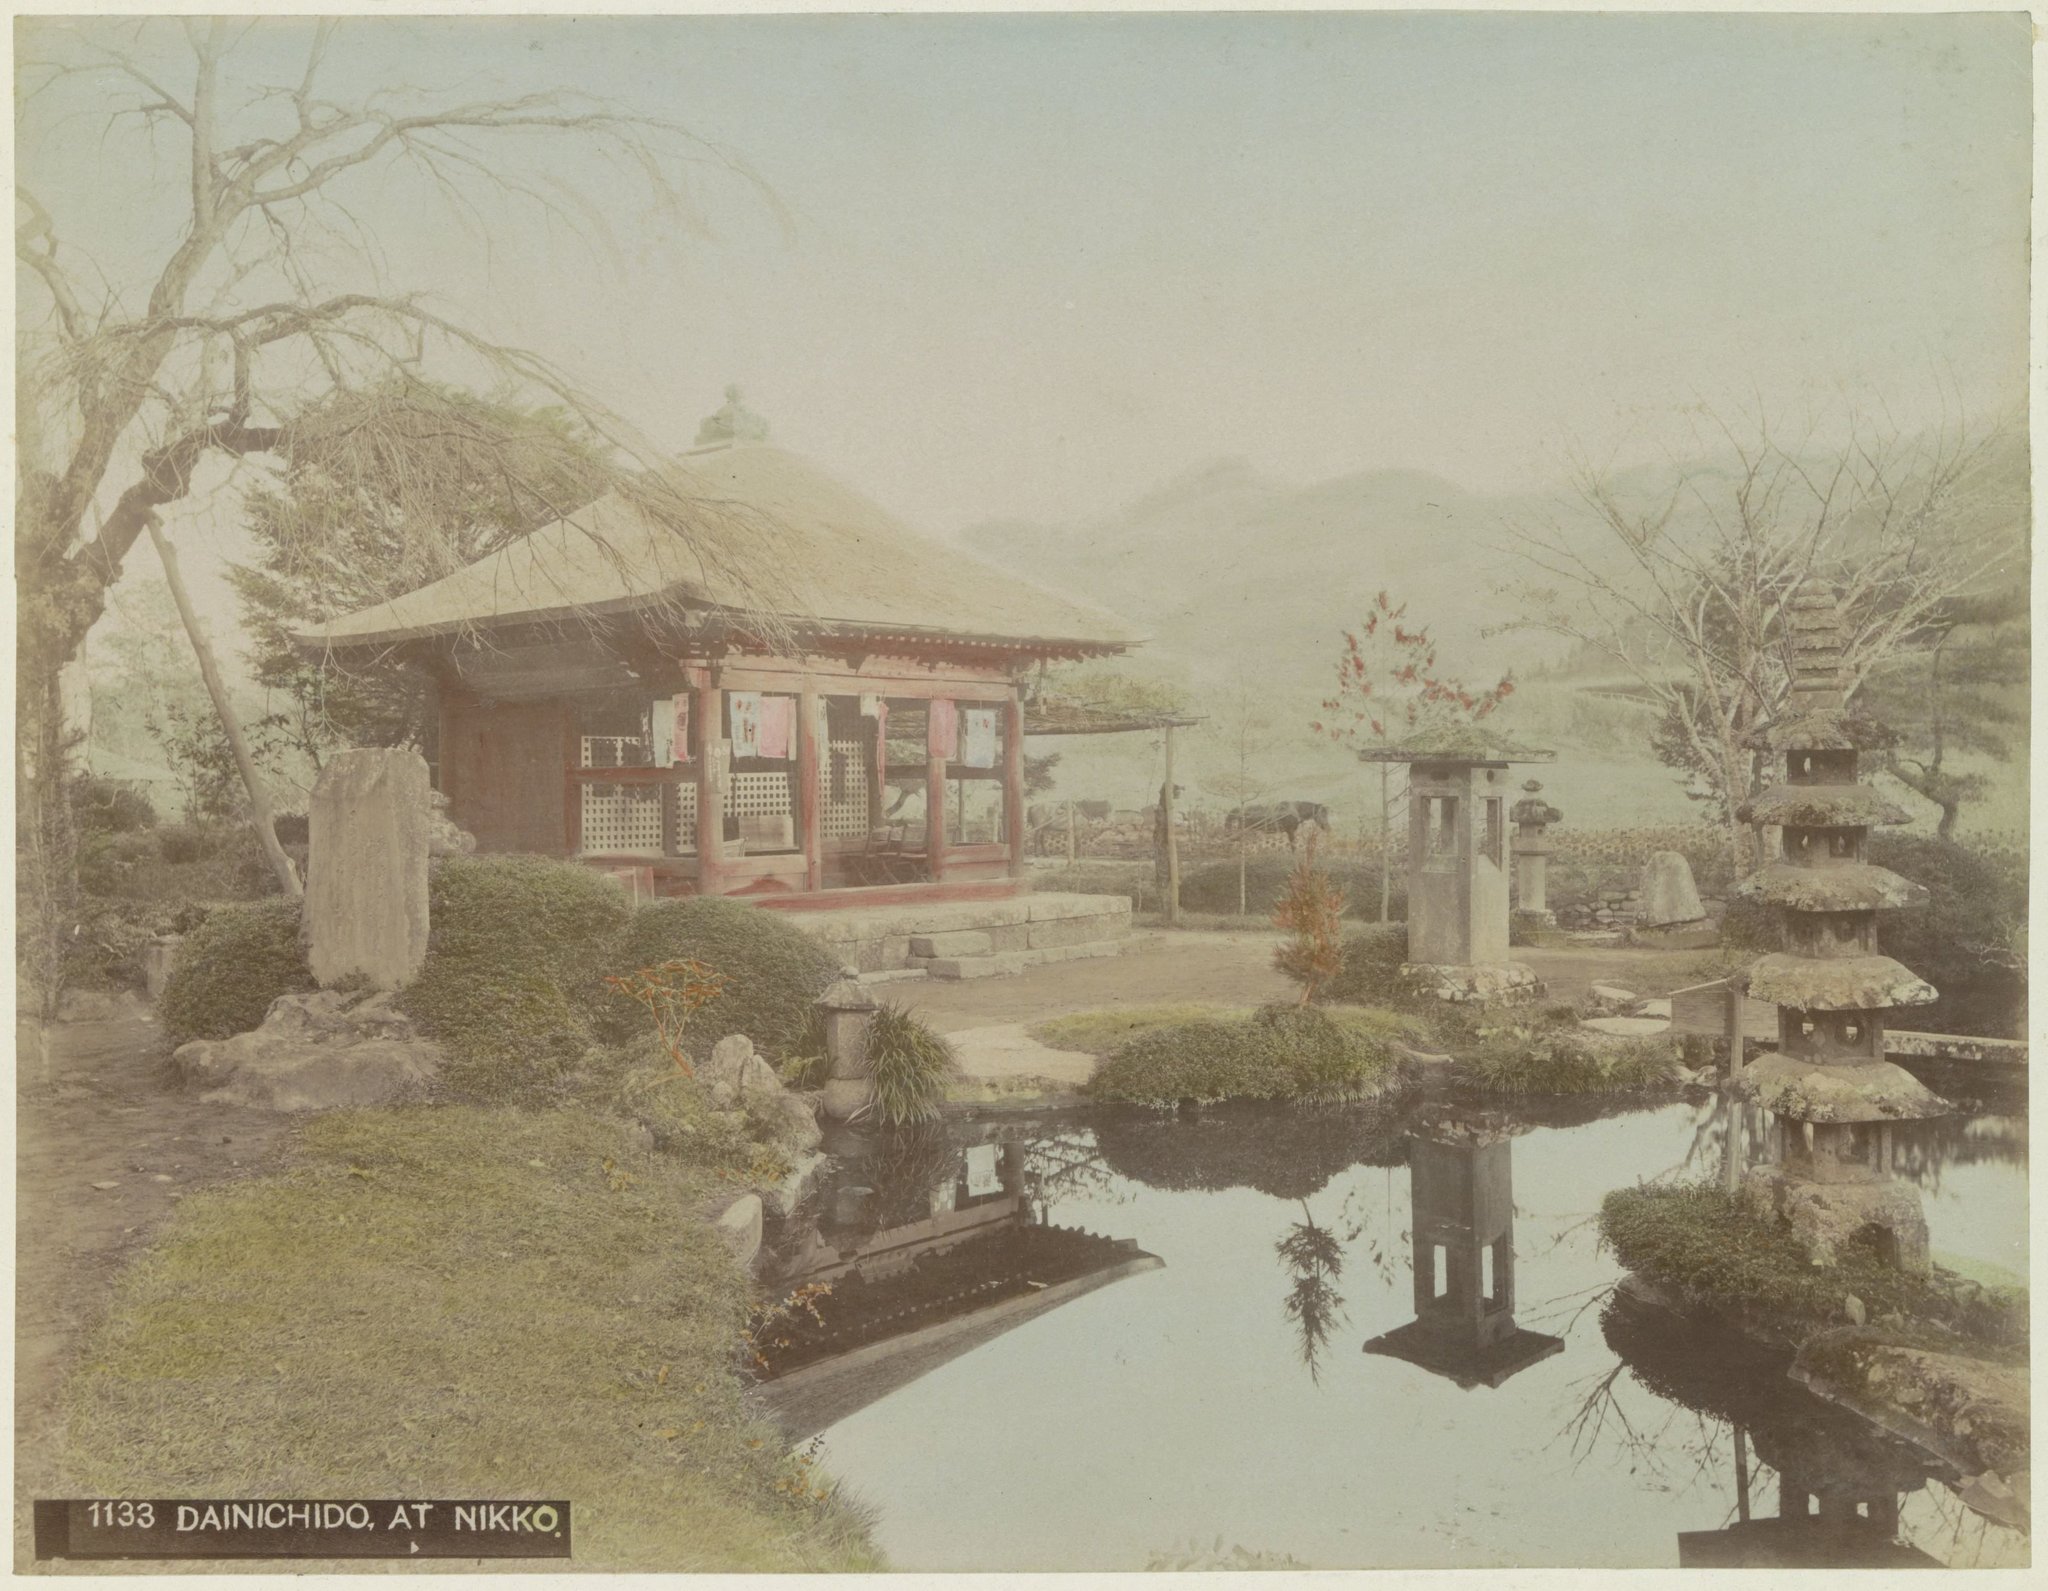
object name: photograph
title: Dainichido, at Nikko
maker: Anonymous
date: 1870-1900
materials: cardboard, paper, photographic support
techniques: albumen print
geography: nikko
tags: temple, shrine ~ hinduism, buddhism, jainism, garden, garden pond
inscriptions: negative number: ‘1133’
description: Onderdeel van Reisalbum met foto's van bezienswaardigheden in Japan.